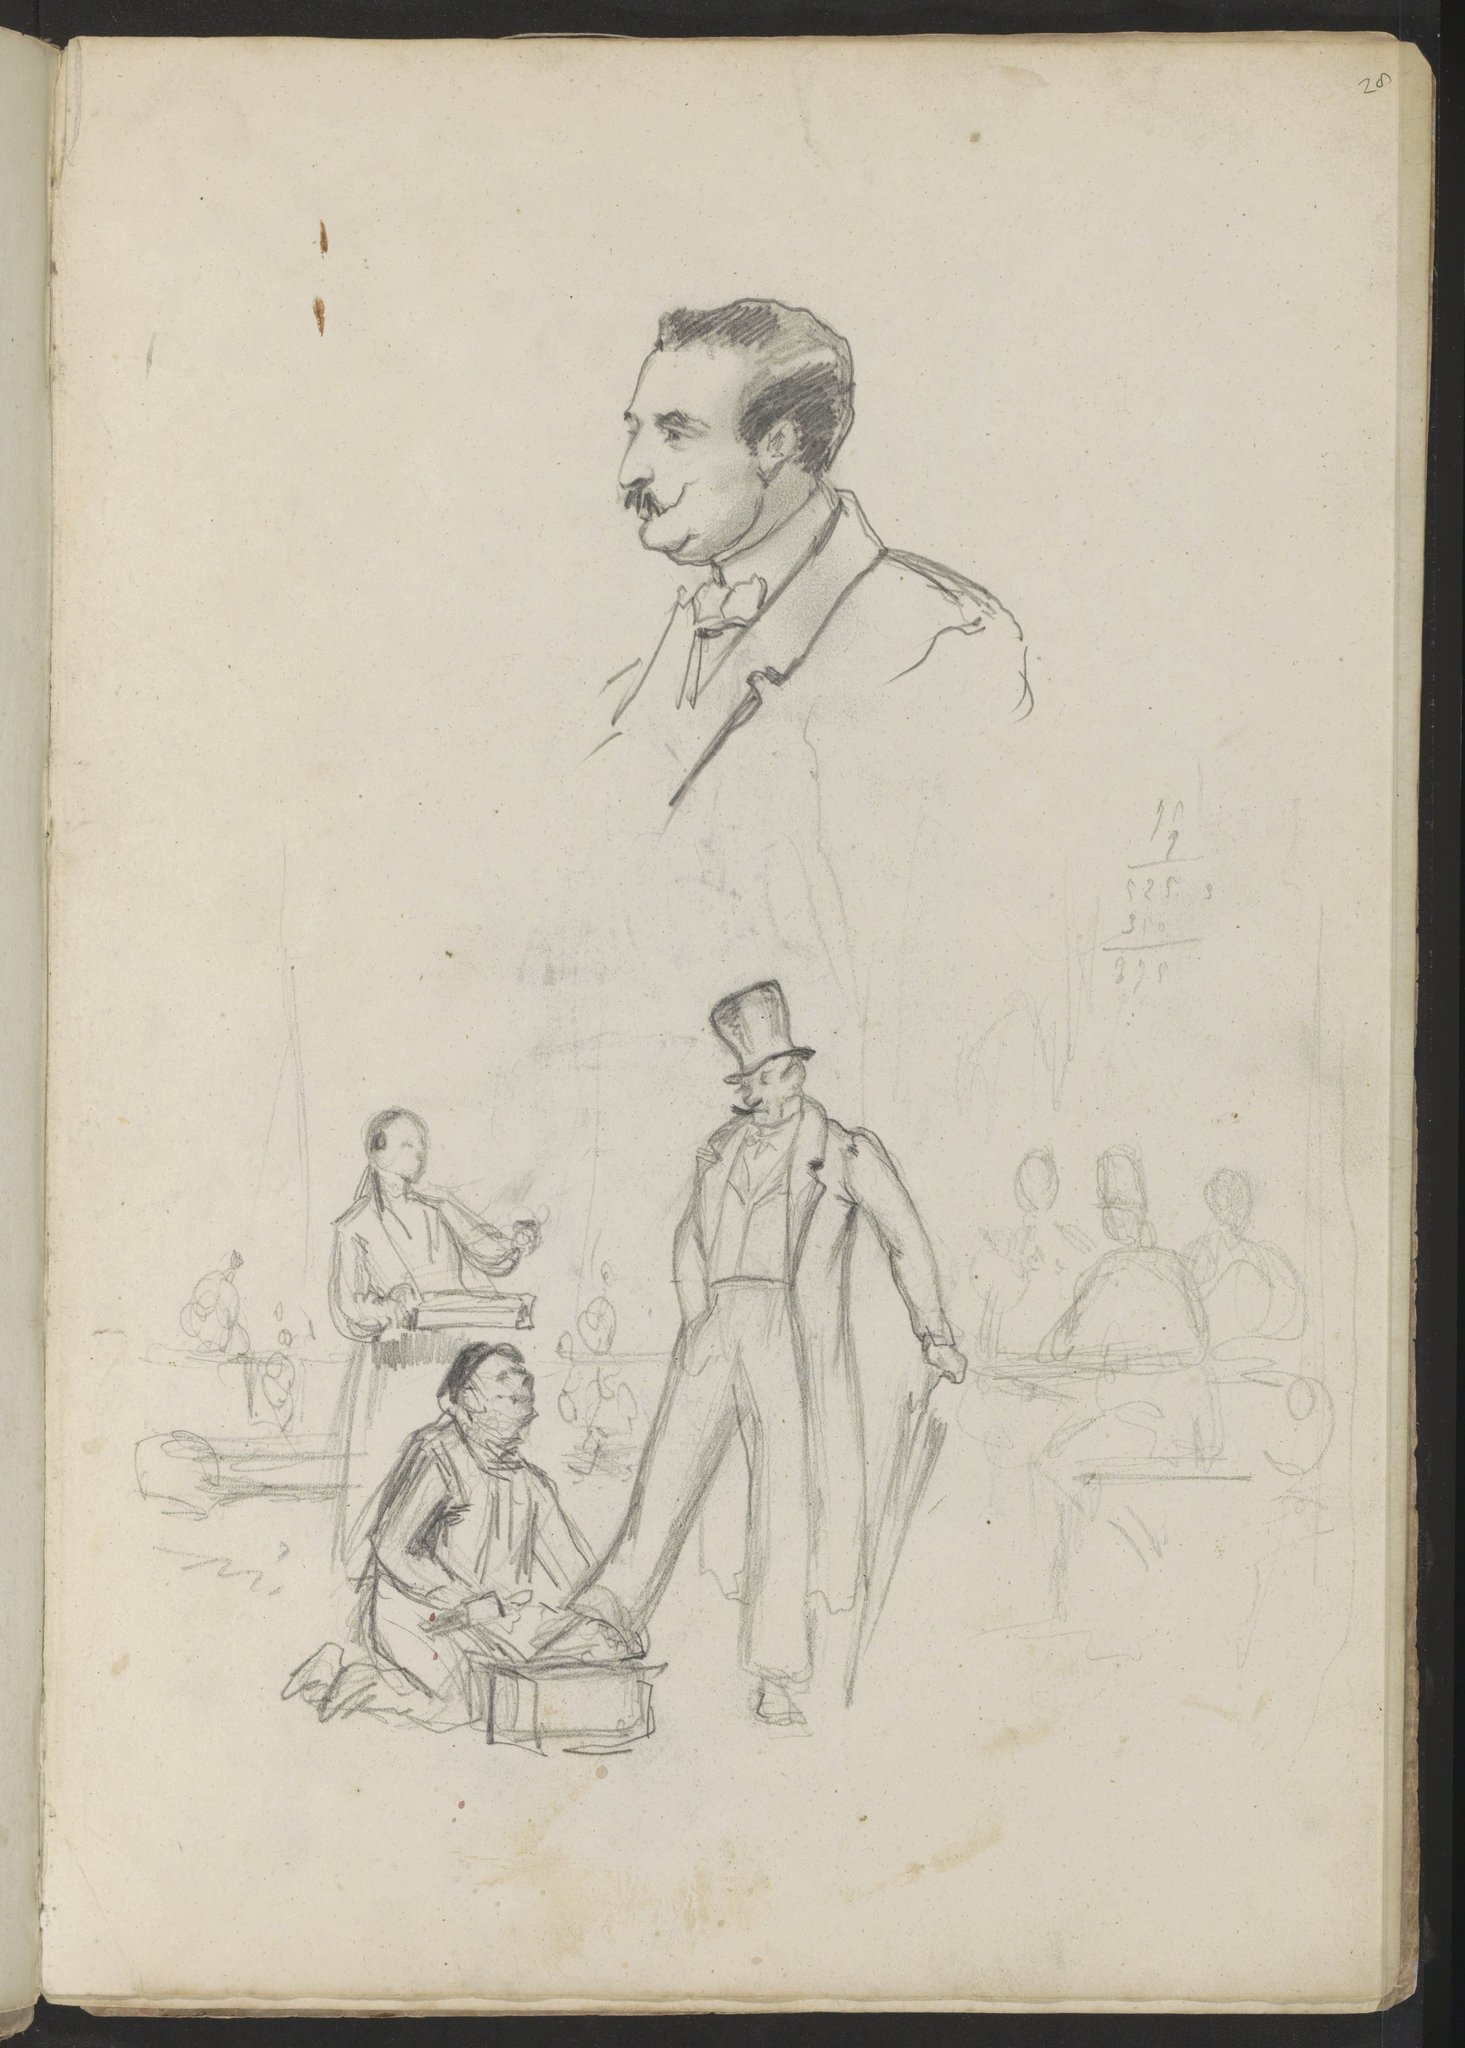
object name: sketchbook leaf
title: Straatgezicht met een verkoper en schoenenpoetser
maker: johannes huybertus van hove bzn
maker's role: print maker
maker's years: 1827-1881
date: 1837-1881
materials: paper, pencil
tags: head (human), persons engaged in trade and commerce, street (+ city(-scape) with figures, staffage)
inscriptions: annotation: ‘[...]’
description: Tevens een studie van een man met een snor. Blad 28 recto uit een schetsboek met 33 bladen en 10 losse tekeningen.